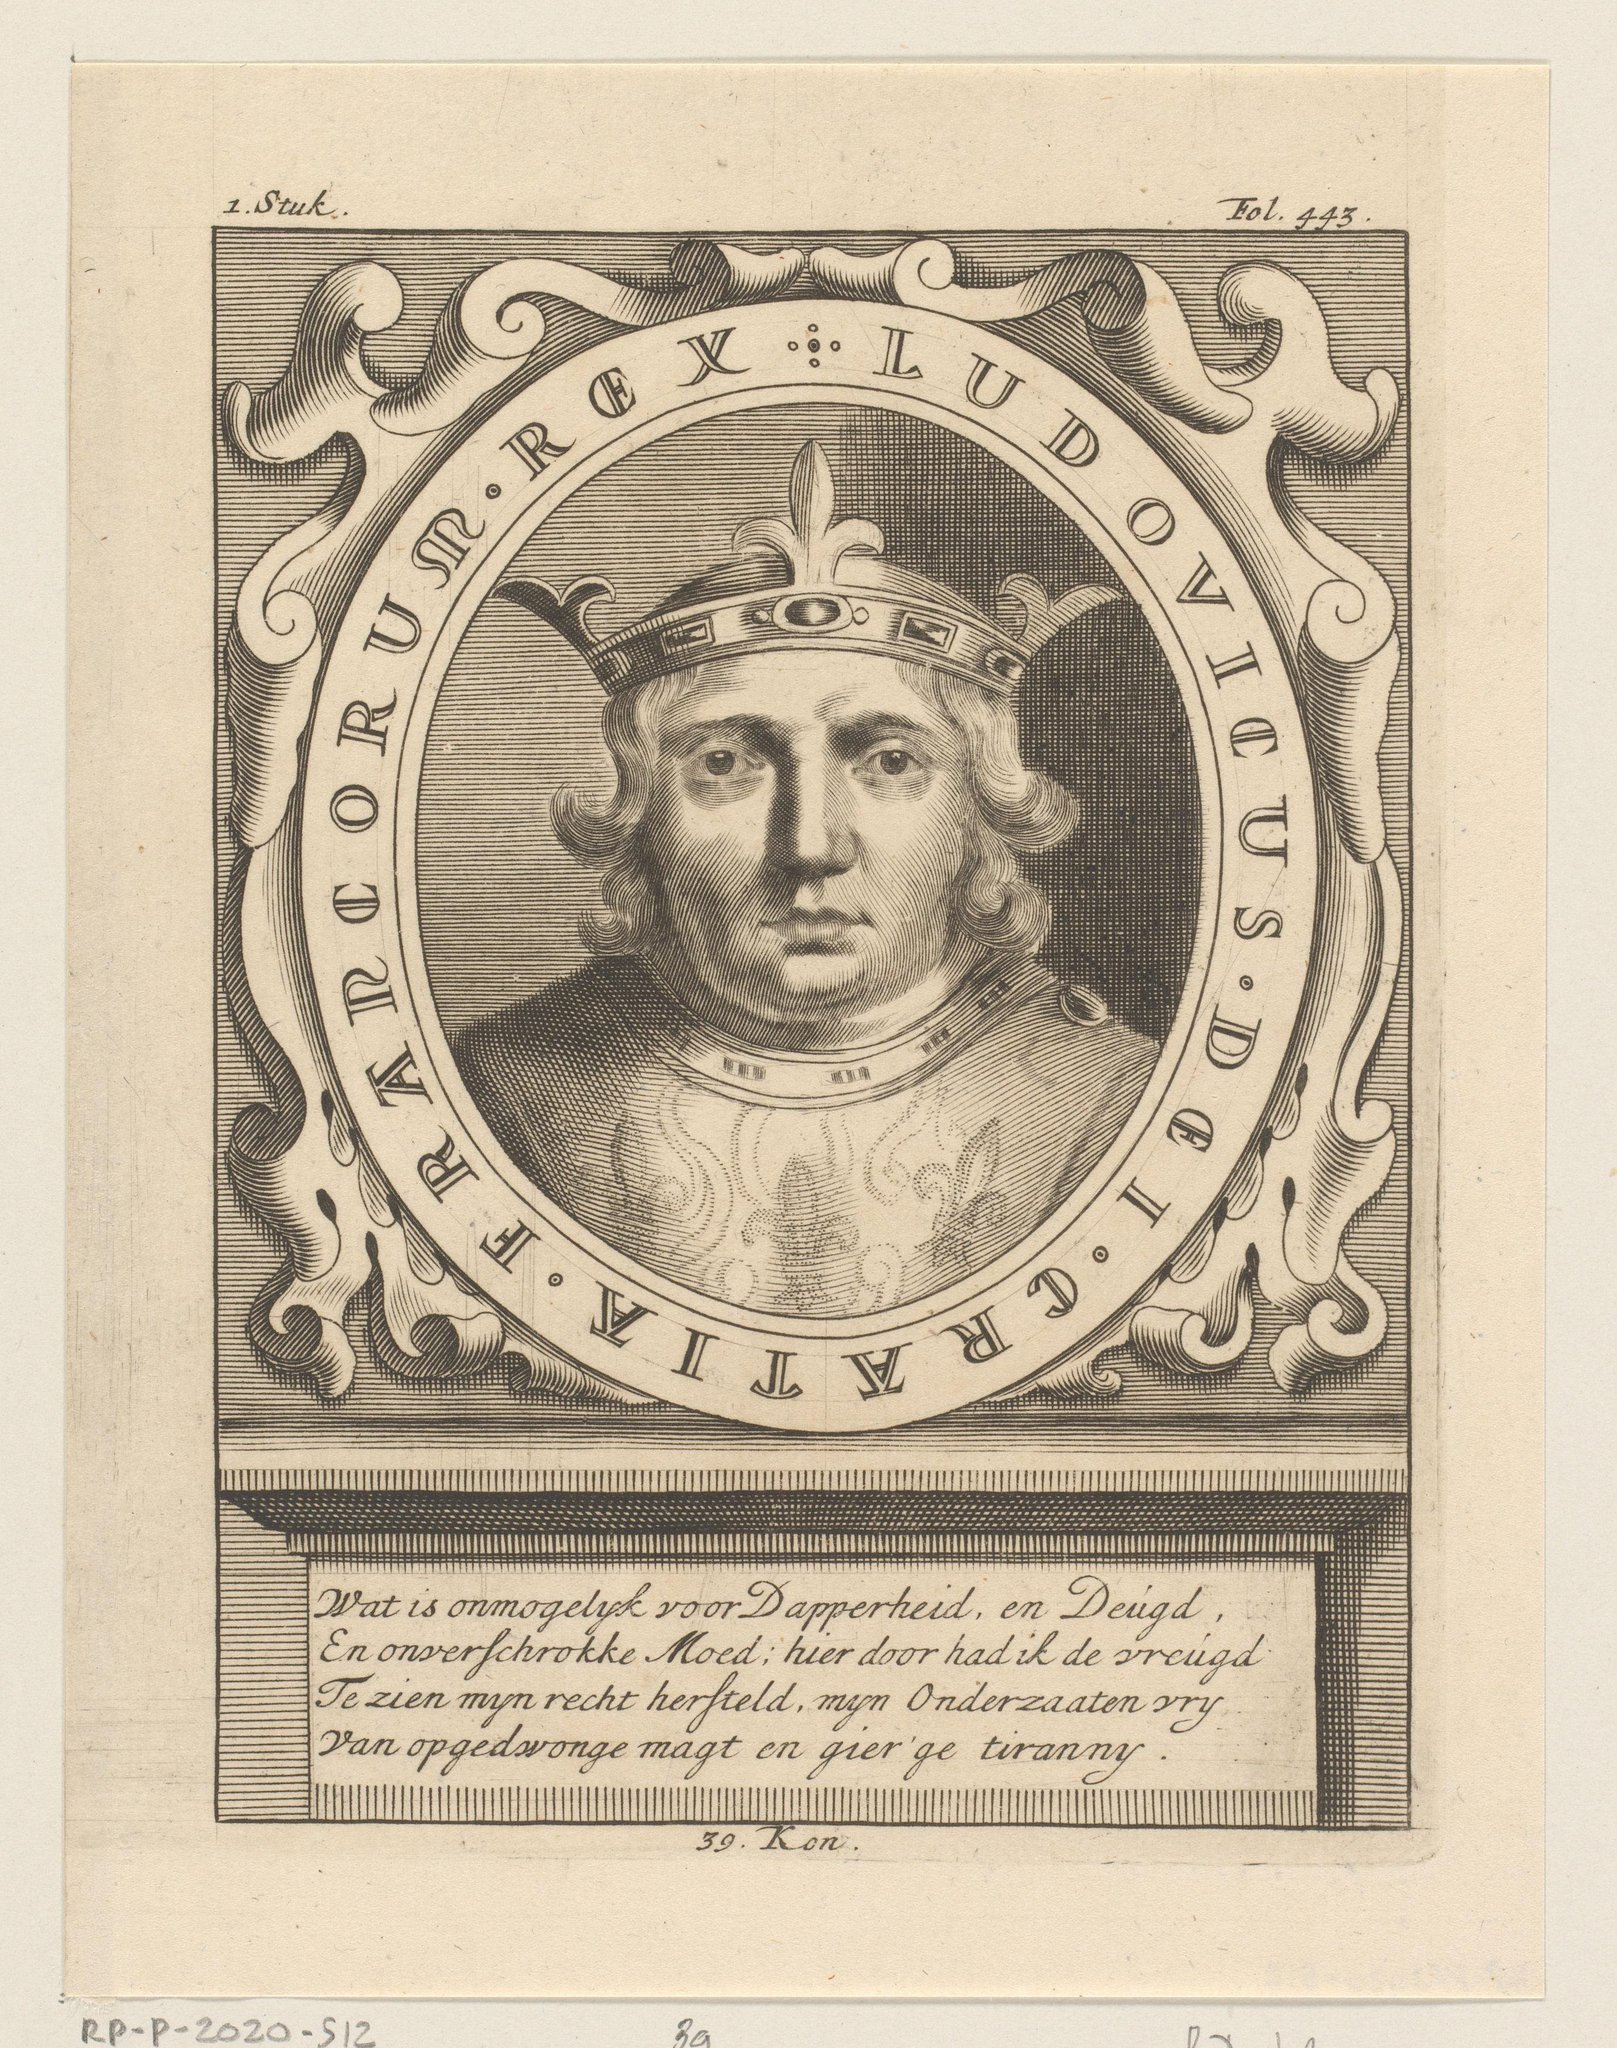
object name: book illustration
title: Portret van Lodewijk VI, koning van Frankrijk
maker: Anonymous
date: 1685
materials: paper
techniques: engraving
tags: paris, historical persons, king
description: Prent gebruikt in: Eudes de Mézeray, François. Chronyk van Vrankryk. 6 dln. Amsterdam: Jan Bouman en Timotheum ten Hoorn, 1685, dl. 2.